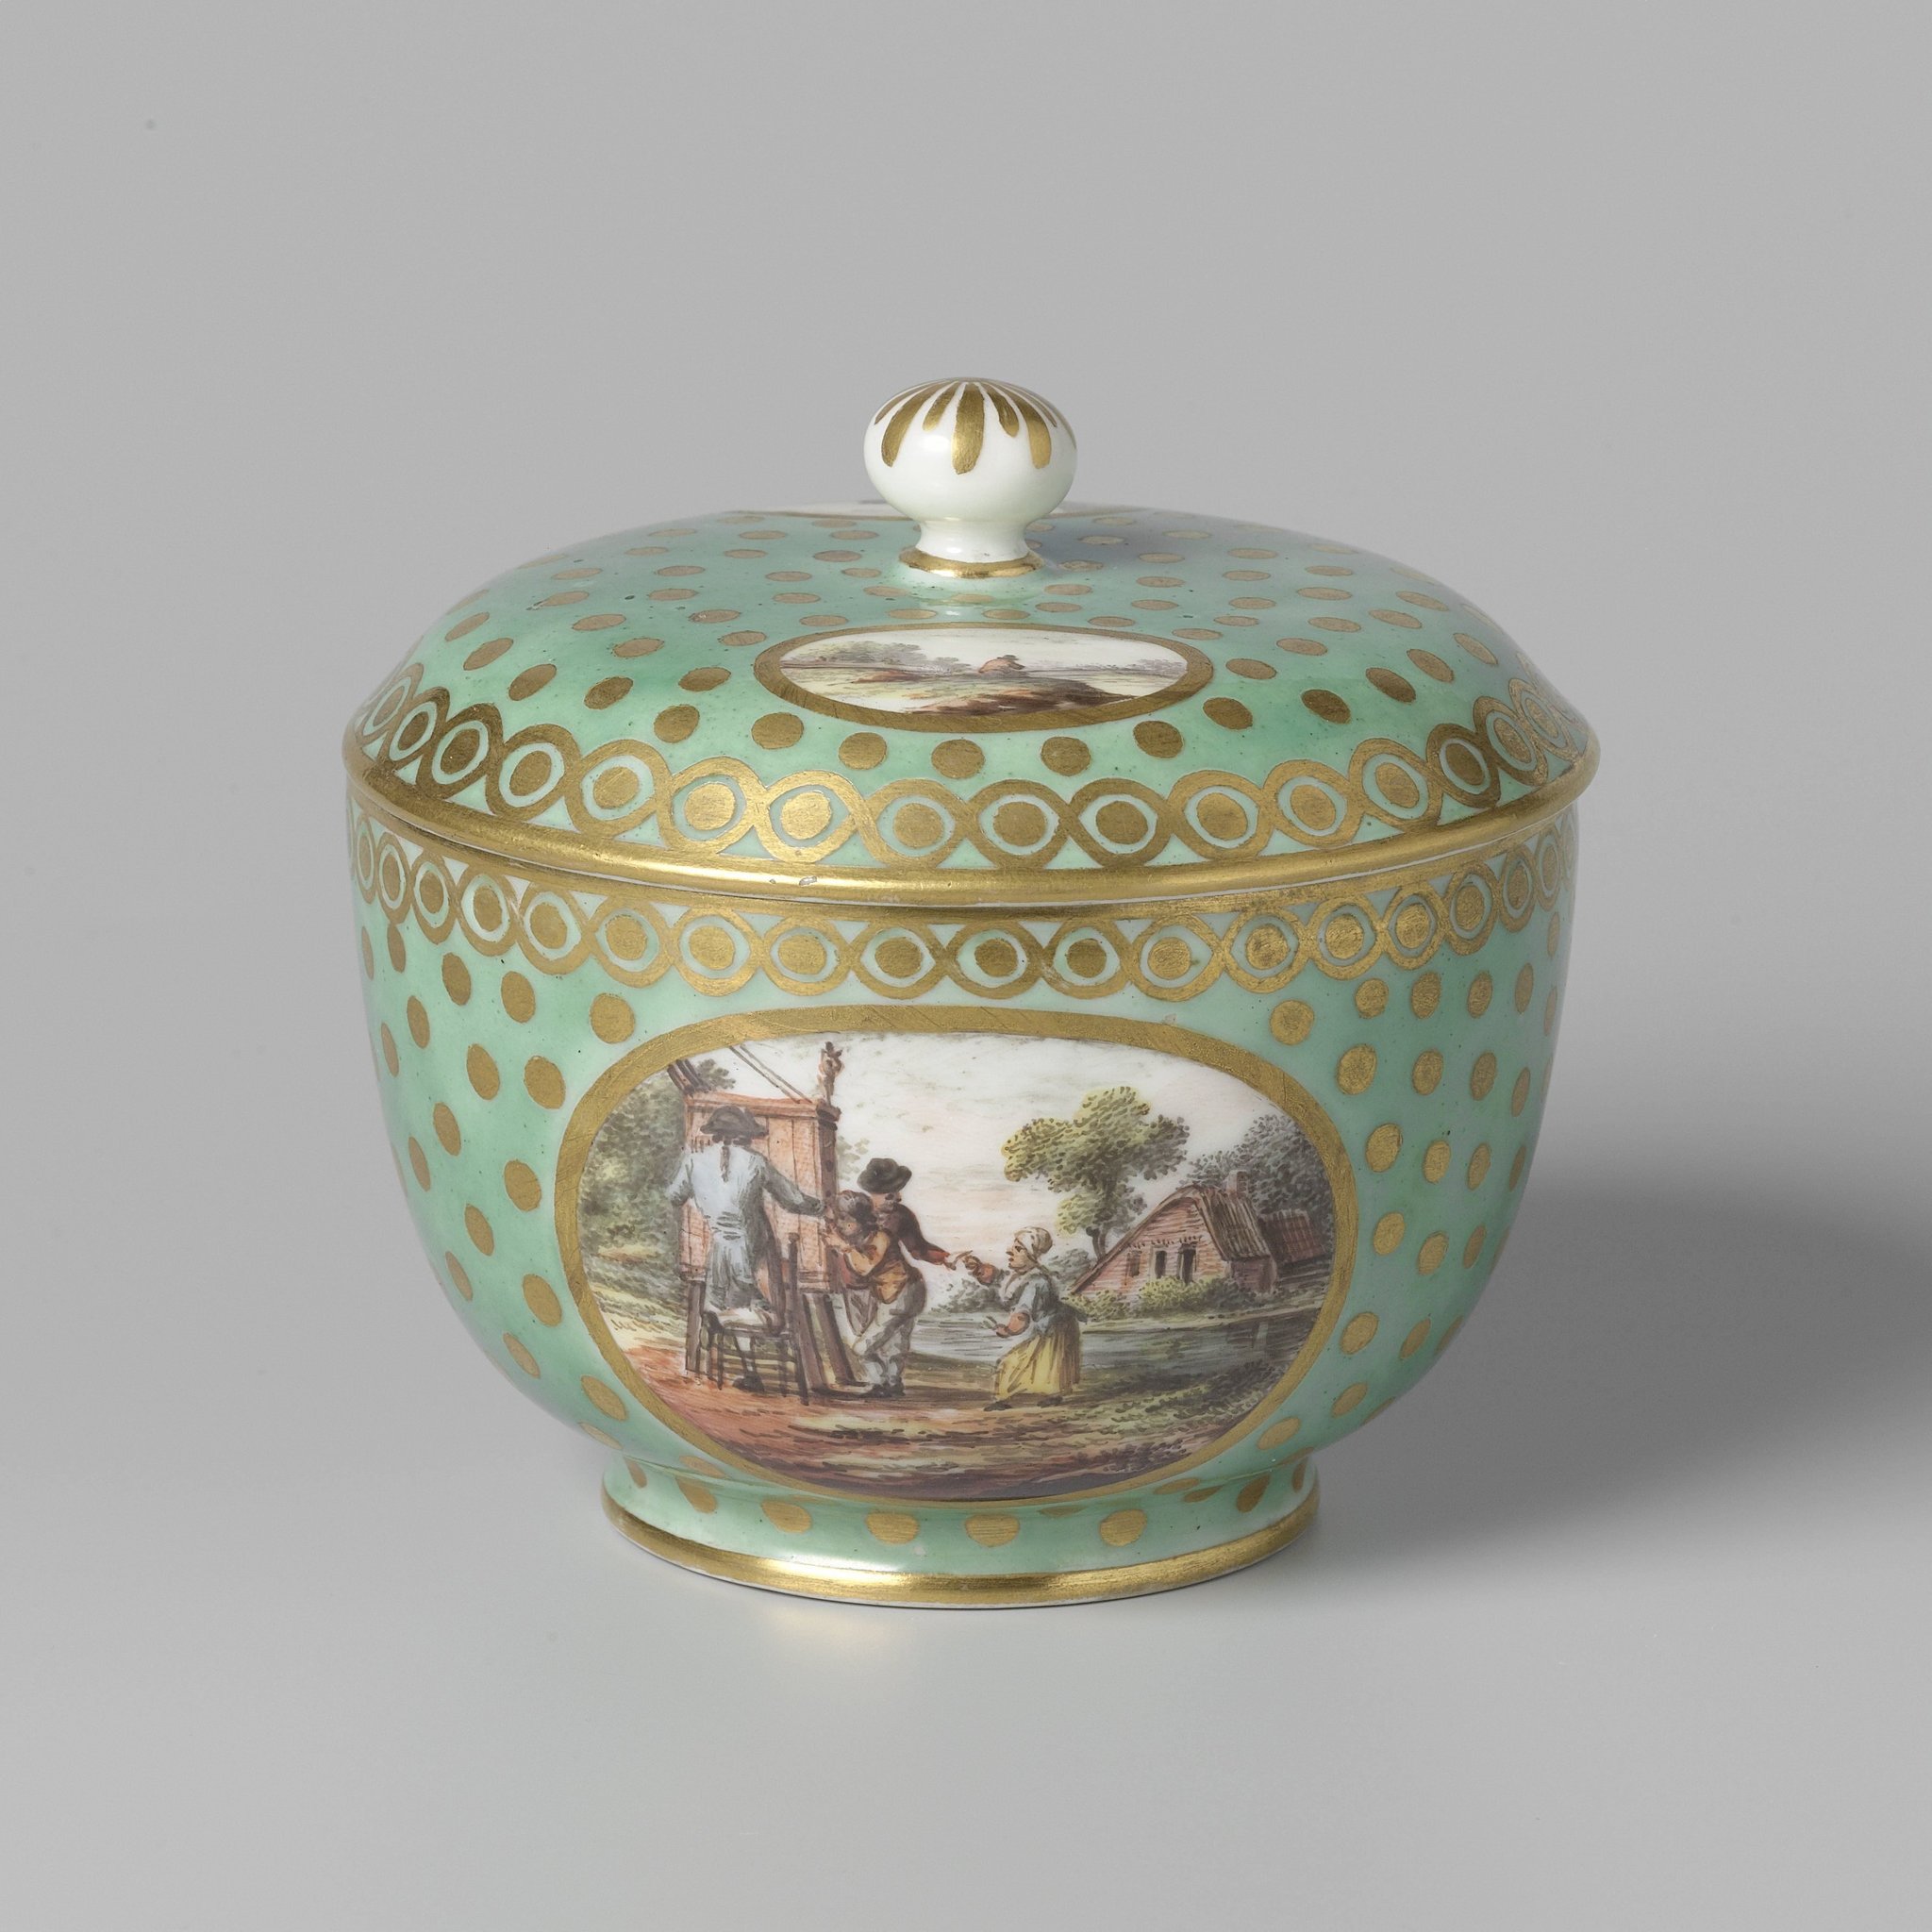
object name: sugar box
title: Tea service for two people (tête-à-tête)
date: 1782-1784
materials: porcelain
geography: loosdrecht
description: Manufactuur Oud-Loosdrecht sugar bowl: Manufactuur Oud-Loosdrecht or Porceleinfabriek aan den Amstel Loosdrecht and Ouder-Amstel, c. 1782–1784 hard-paste porcelain